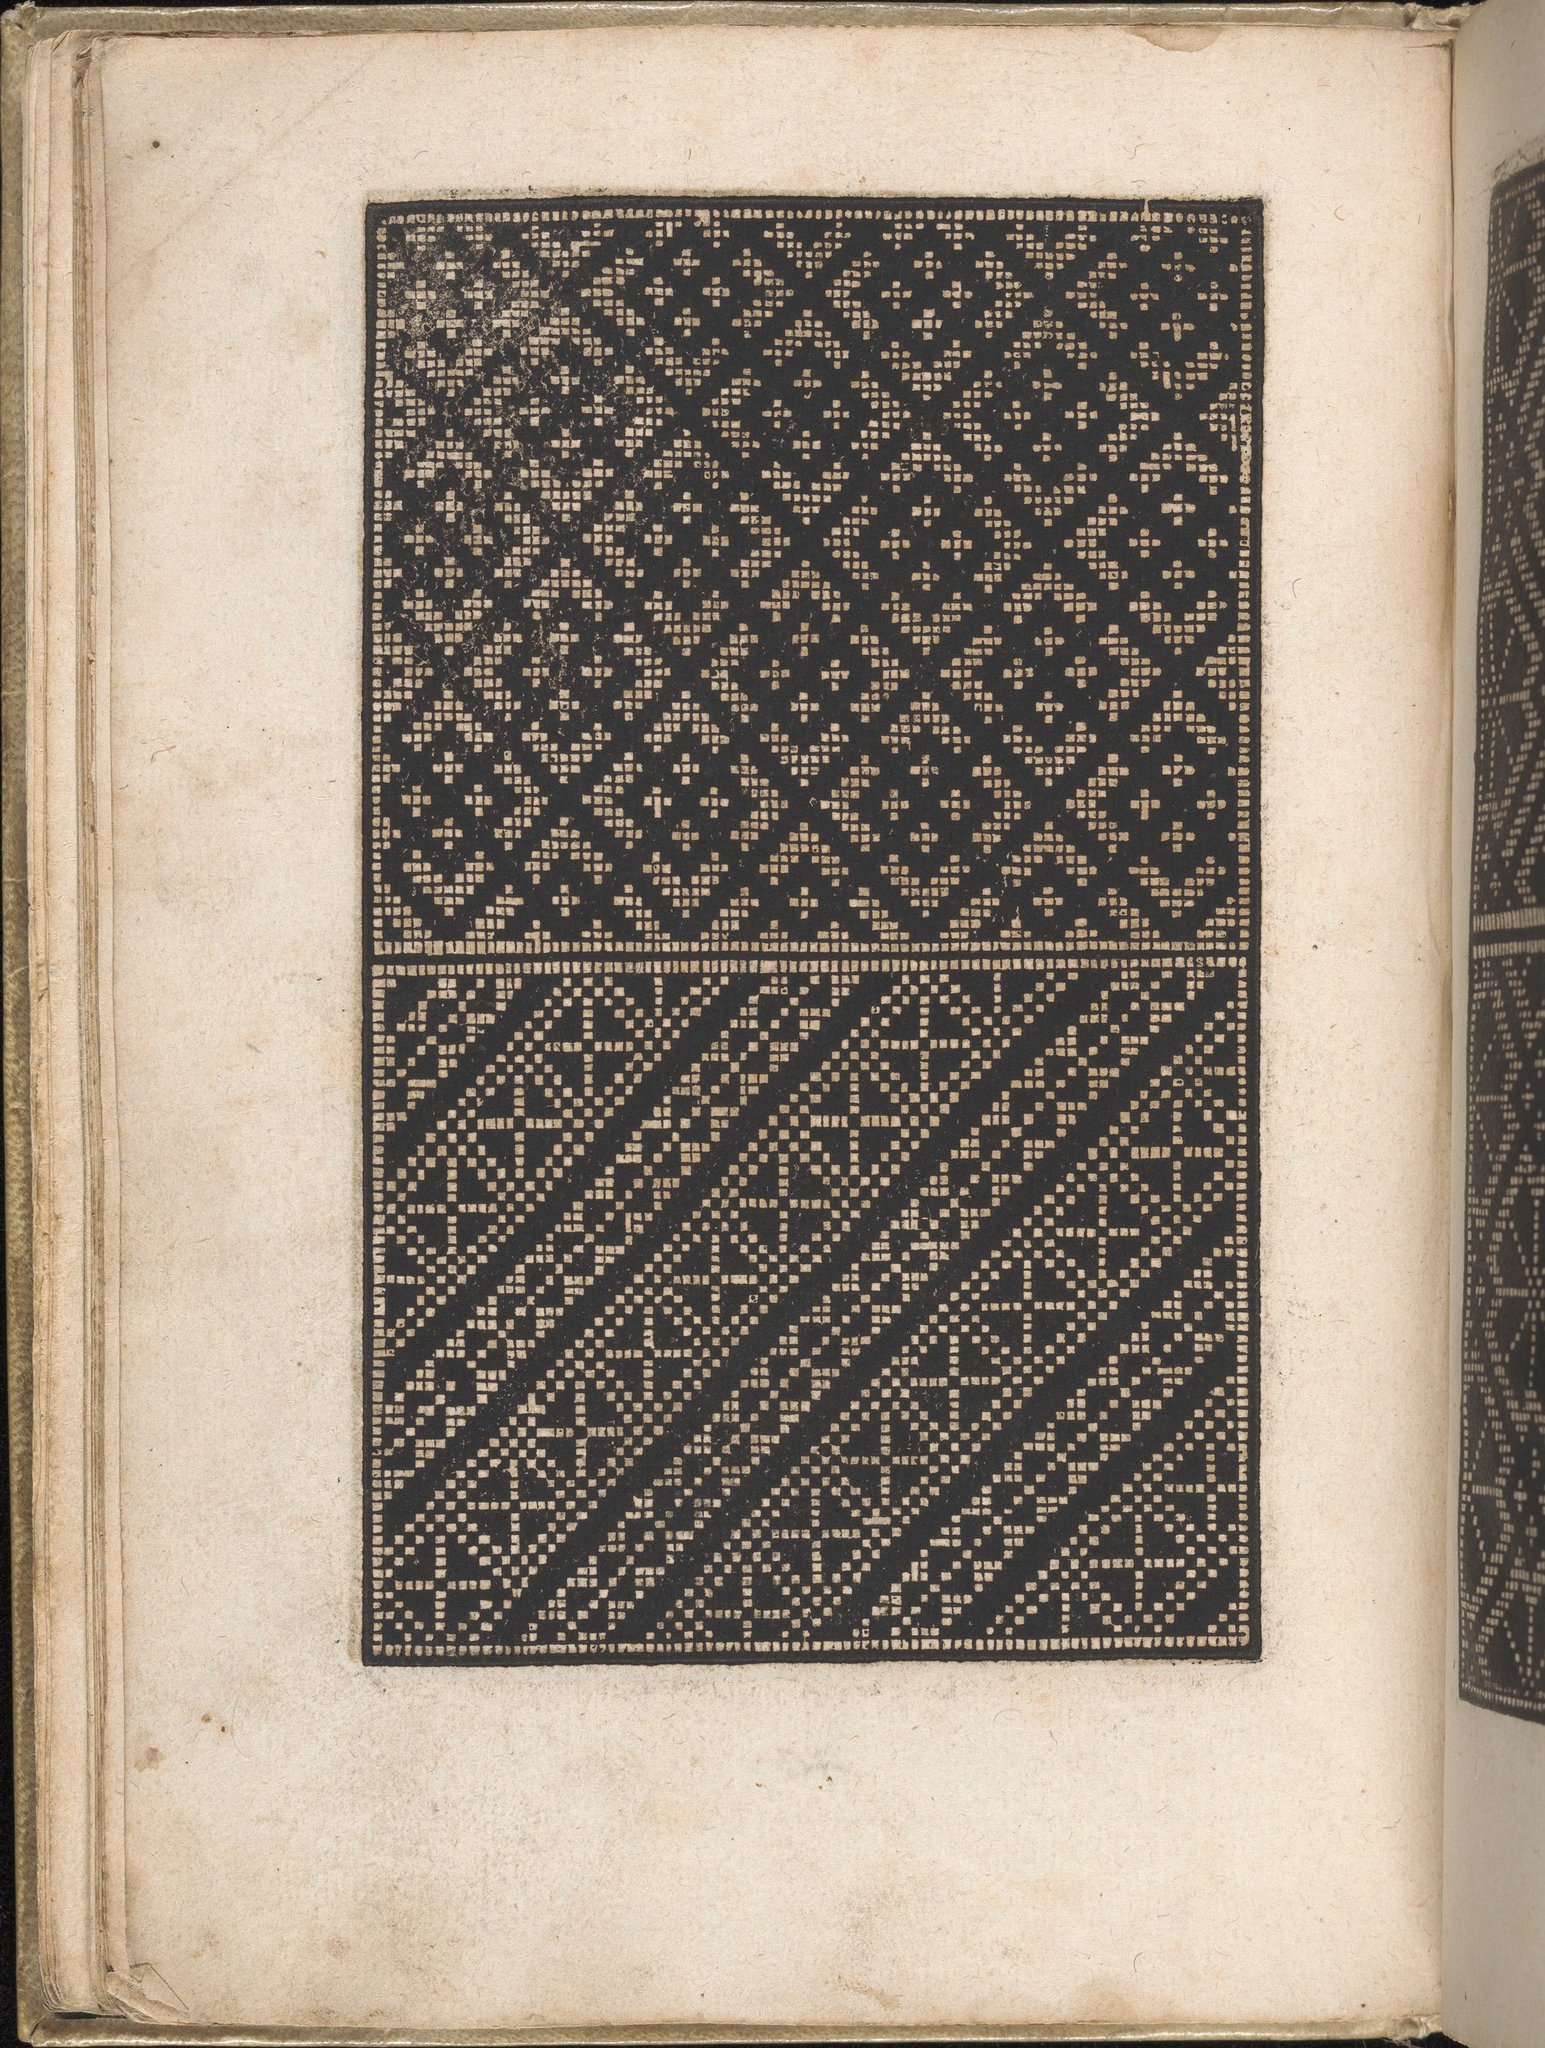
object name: book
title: Page 17v, from "Eyn New Kunstlichboich"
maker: peter quentel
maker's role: publisher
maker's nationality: german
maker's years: 1500-1550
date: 1529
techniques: woodcut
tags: ornament